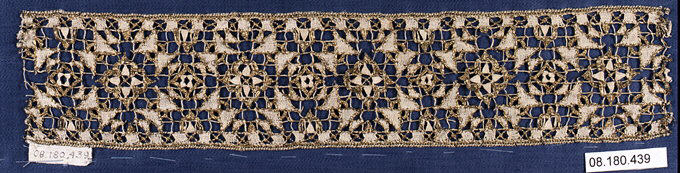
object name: border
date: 1601-1700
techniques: embroidery